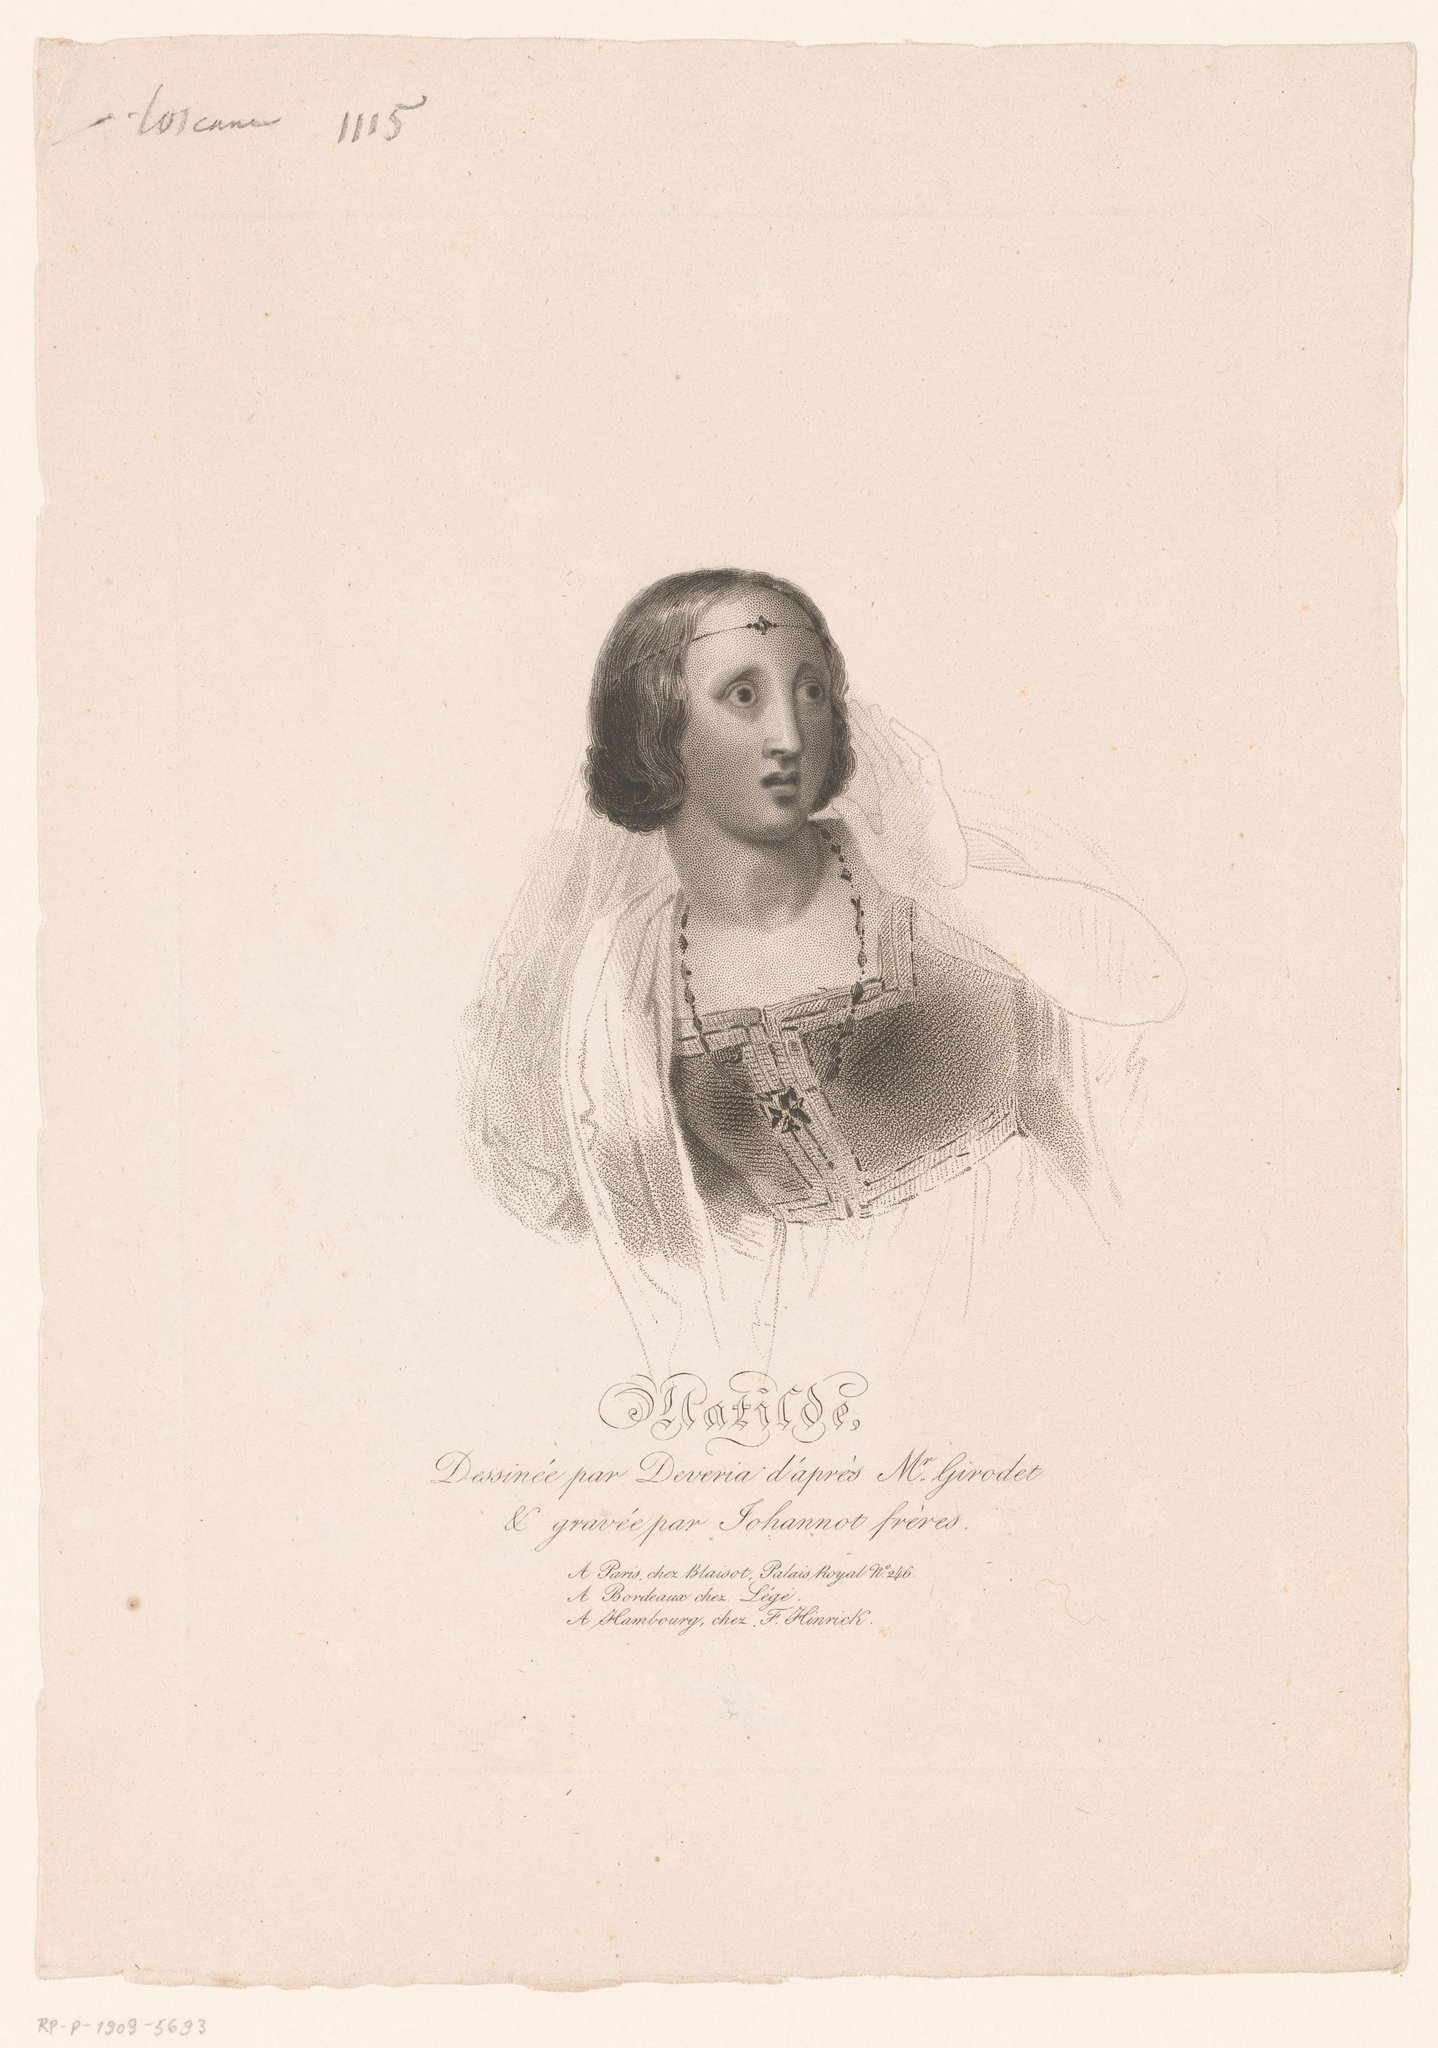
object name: print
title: Portret van Matilde.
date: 1820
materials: paper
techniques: engraving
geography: bordeaux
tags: adult woman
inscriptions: collector's mark: Lugt 2228